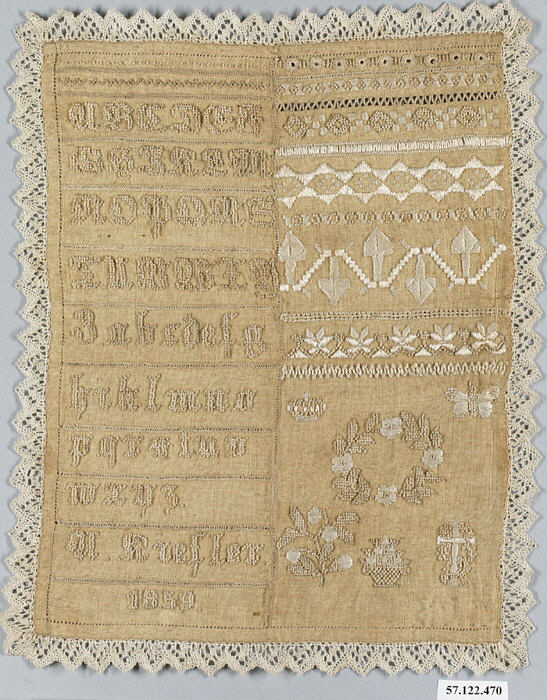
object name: sampler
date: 1859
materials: cotton, silk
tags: flowers